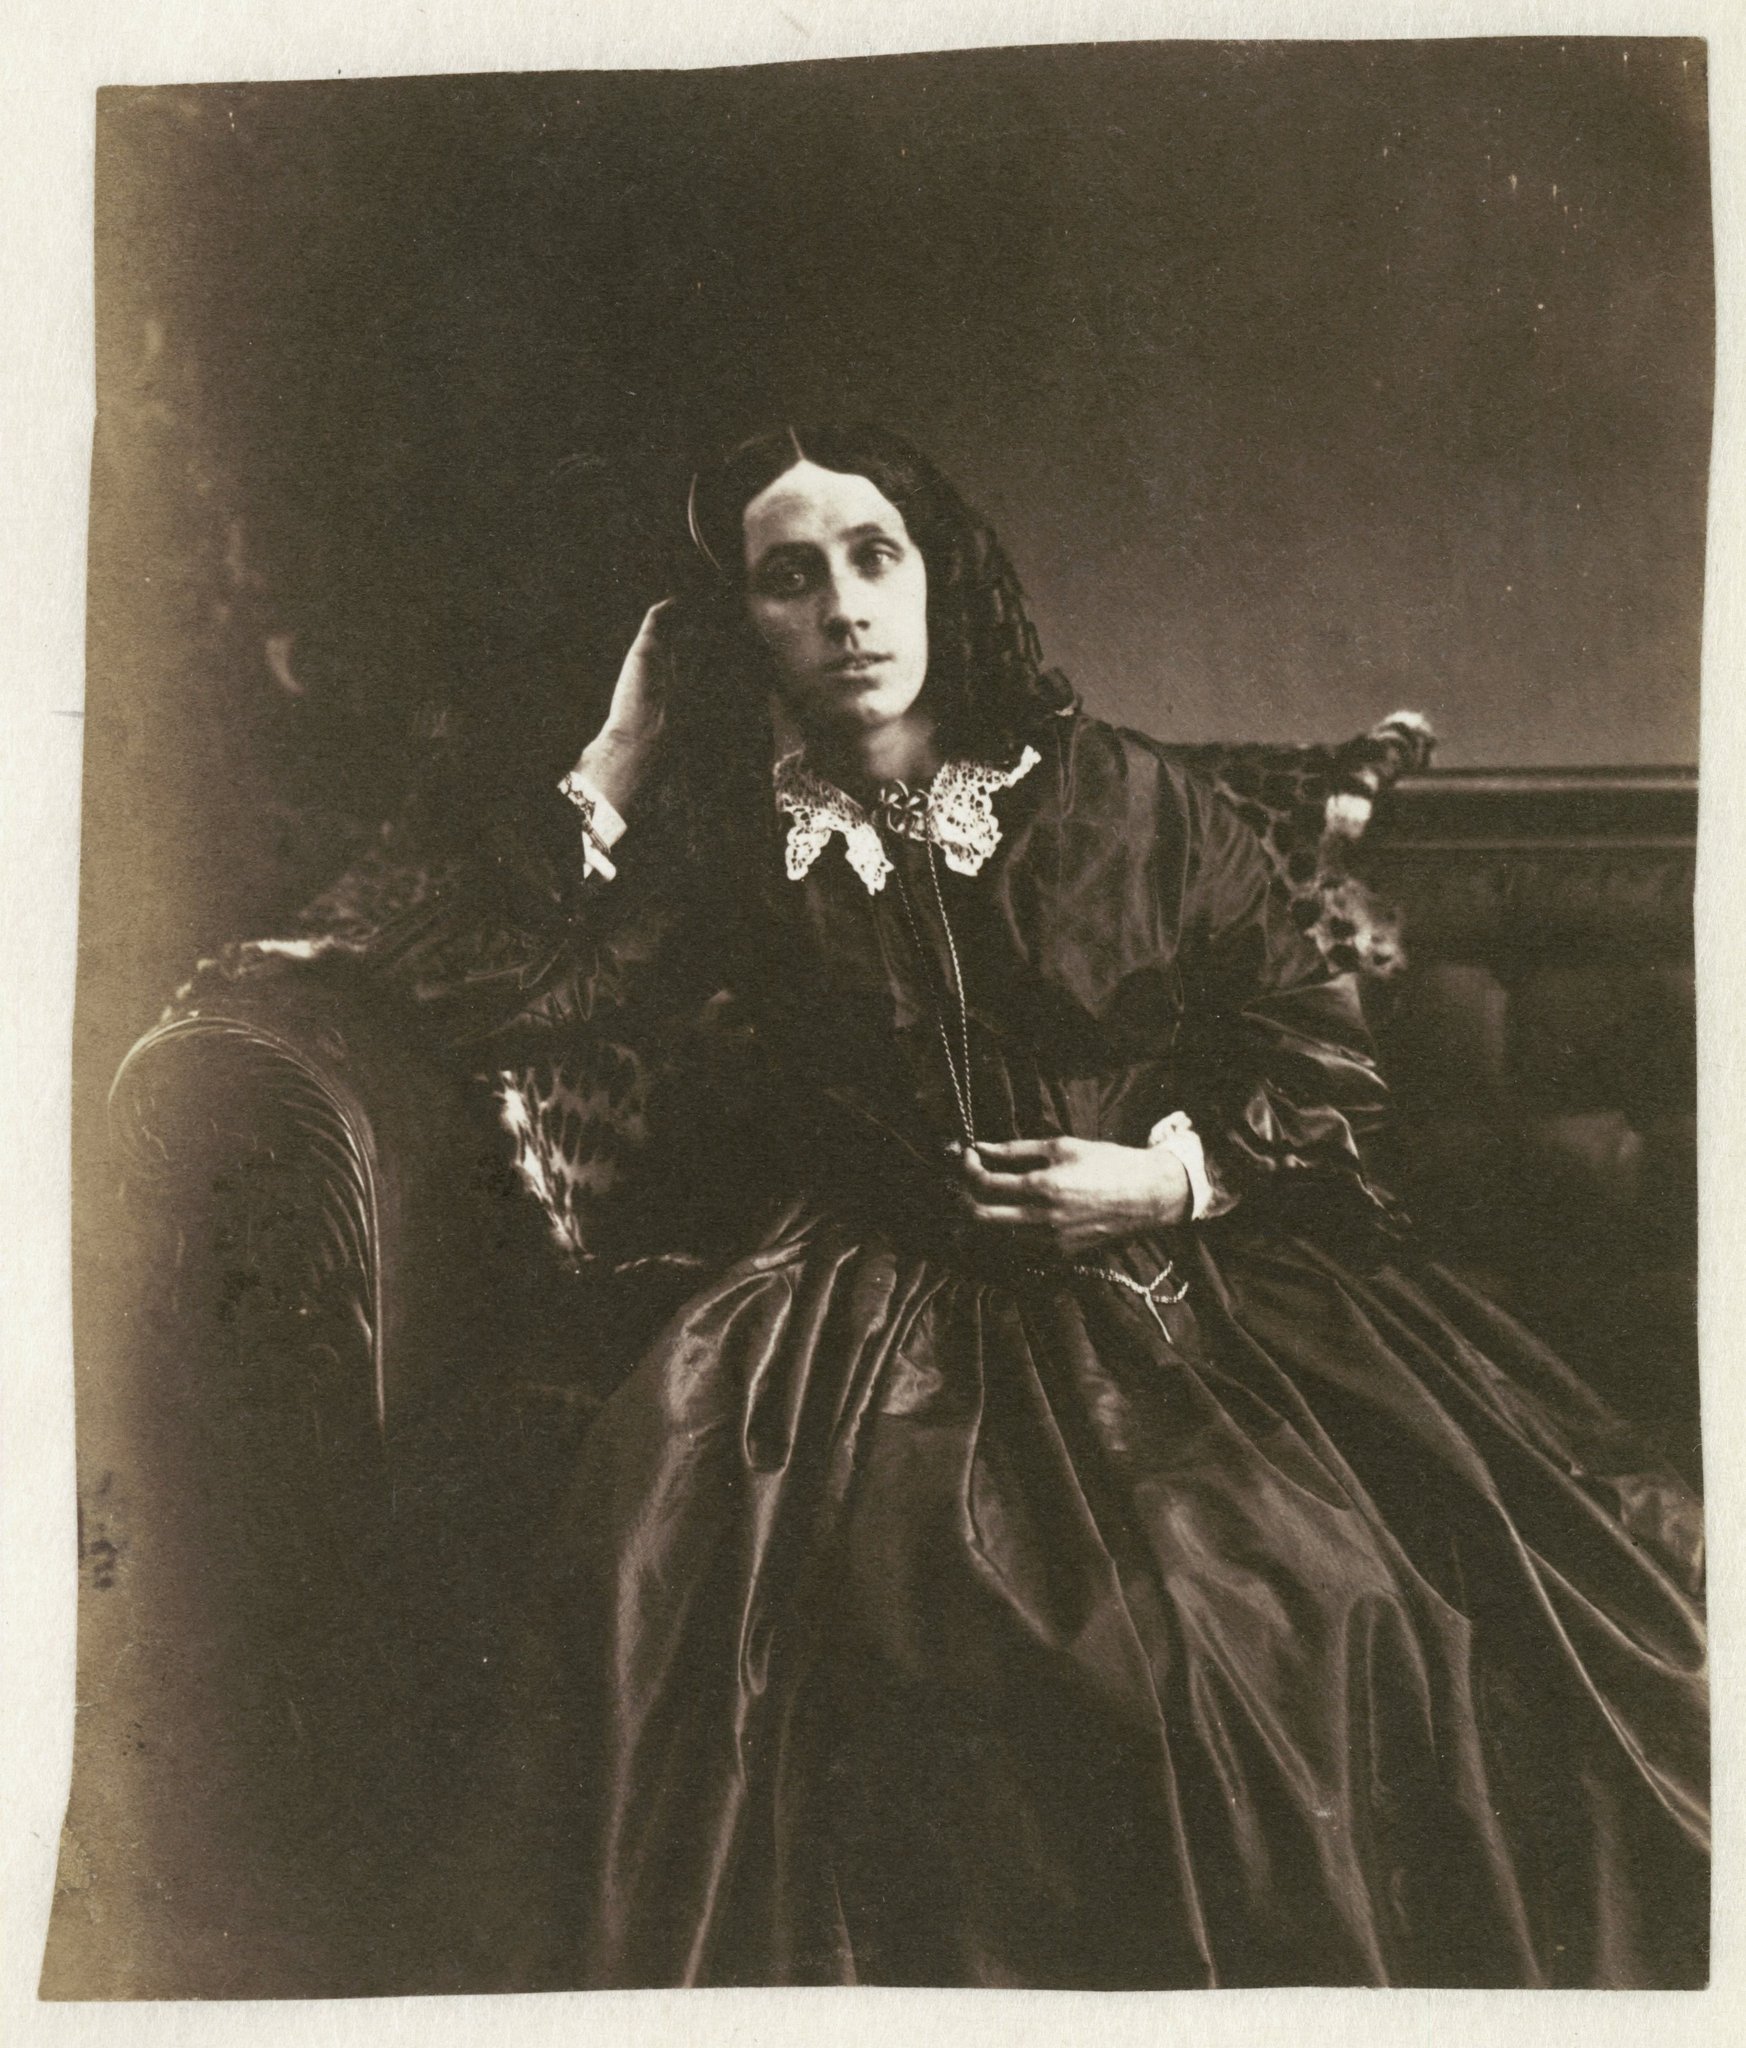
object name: photograph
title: Portret van een onbekende vrouw met pijpenkrullen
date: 1855-1865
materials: photographic support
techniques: salted paper print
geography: great britain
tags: adult woman, anonymous historical person portrayed, great britain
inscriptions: inscription: ‘p’